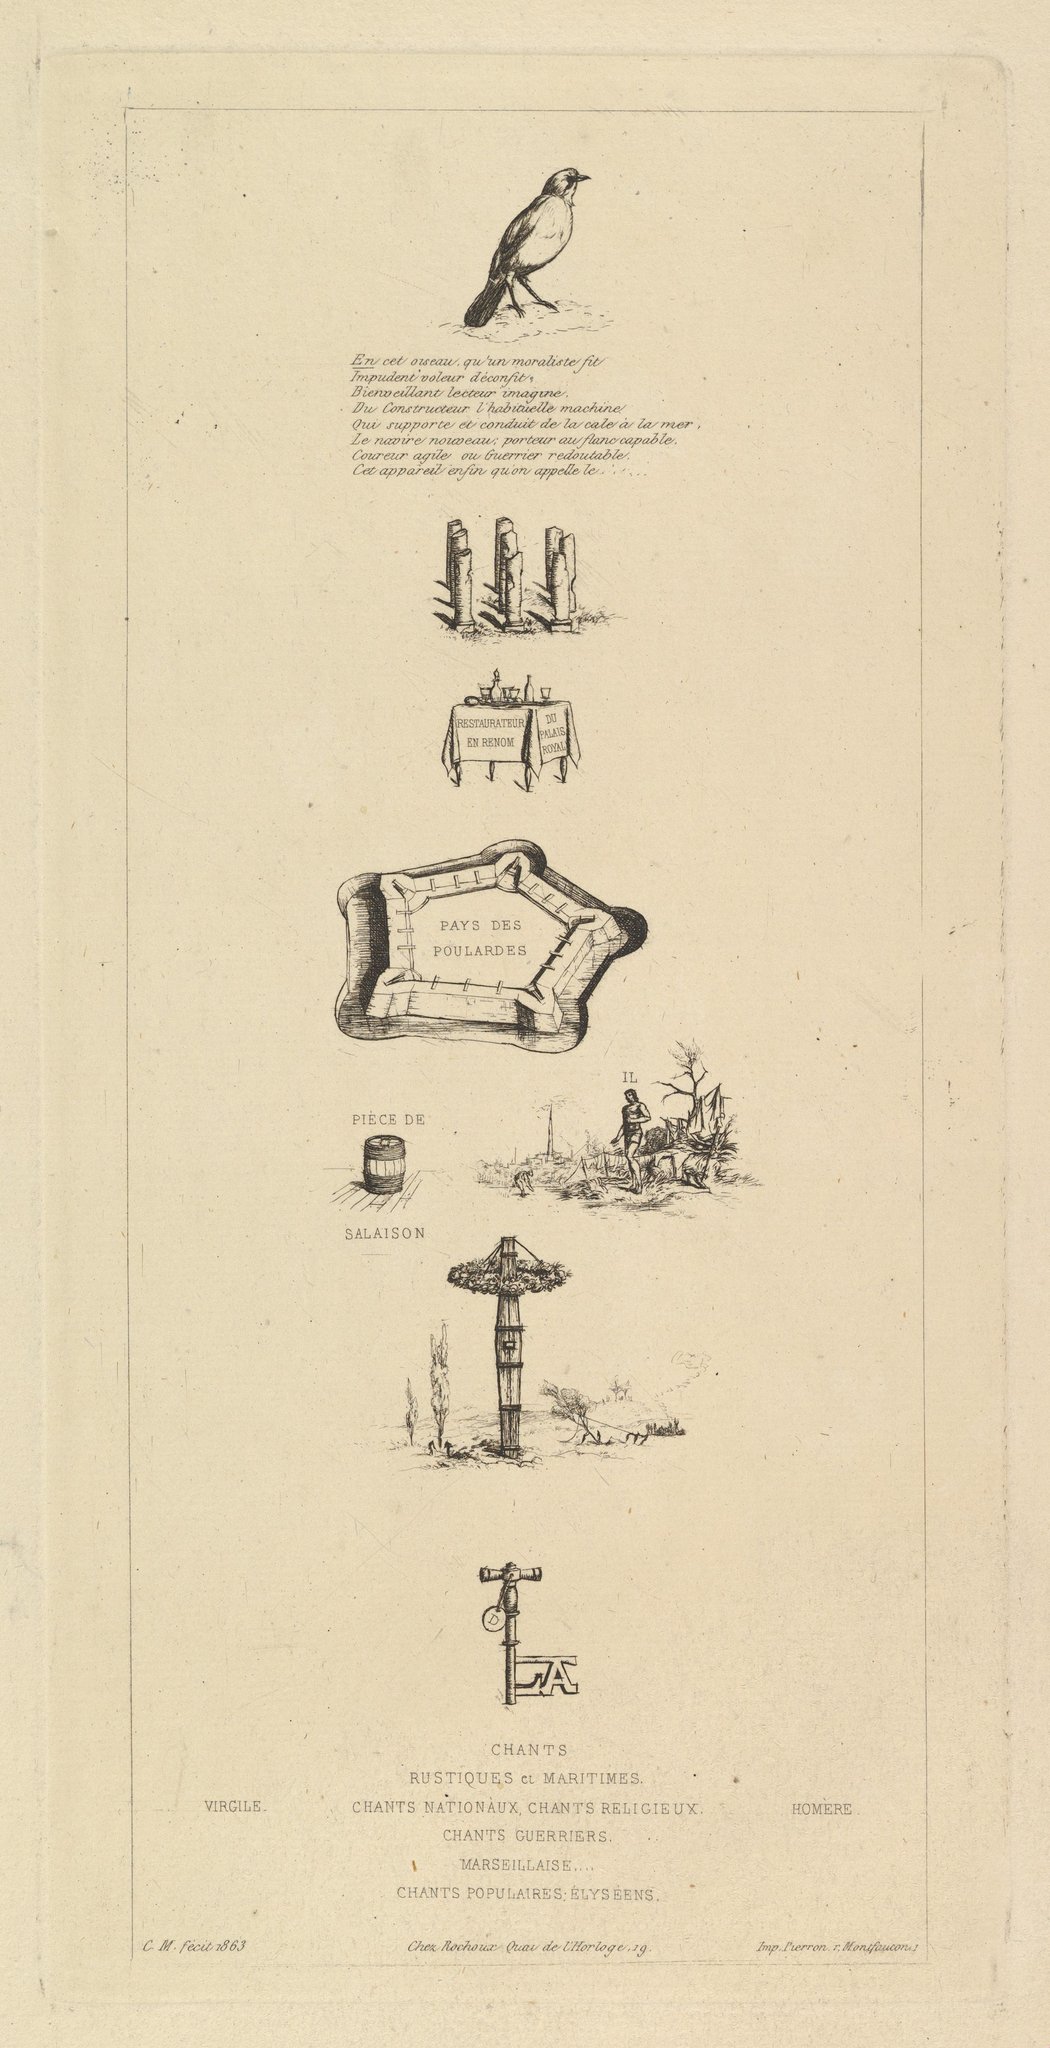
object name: print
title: Rebus: Béranger was not really strong, for he never had the key to the fields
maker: charles meryon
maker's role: artist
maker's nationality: french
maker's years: 1821-1868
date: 1863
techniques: etching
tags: birds